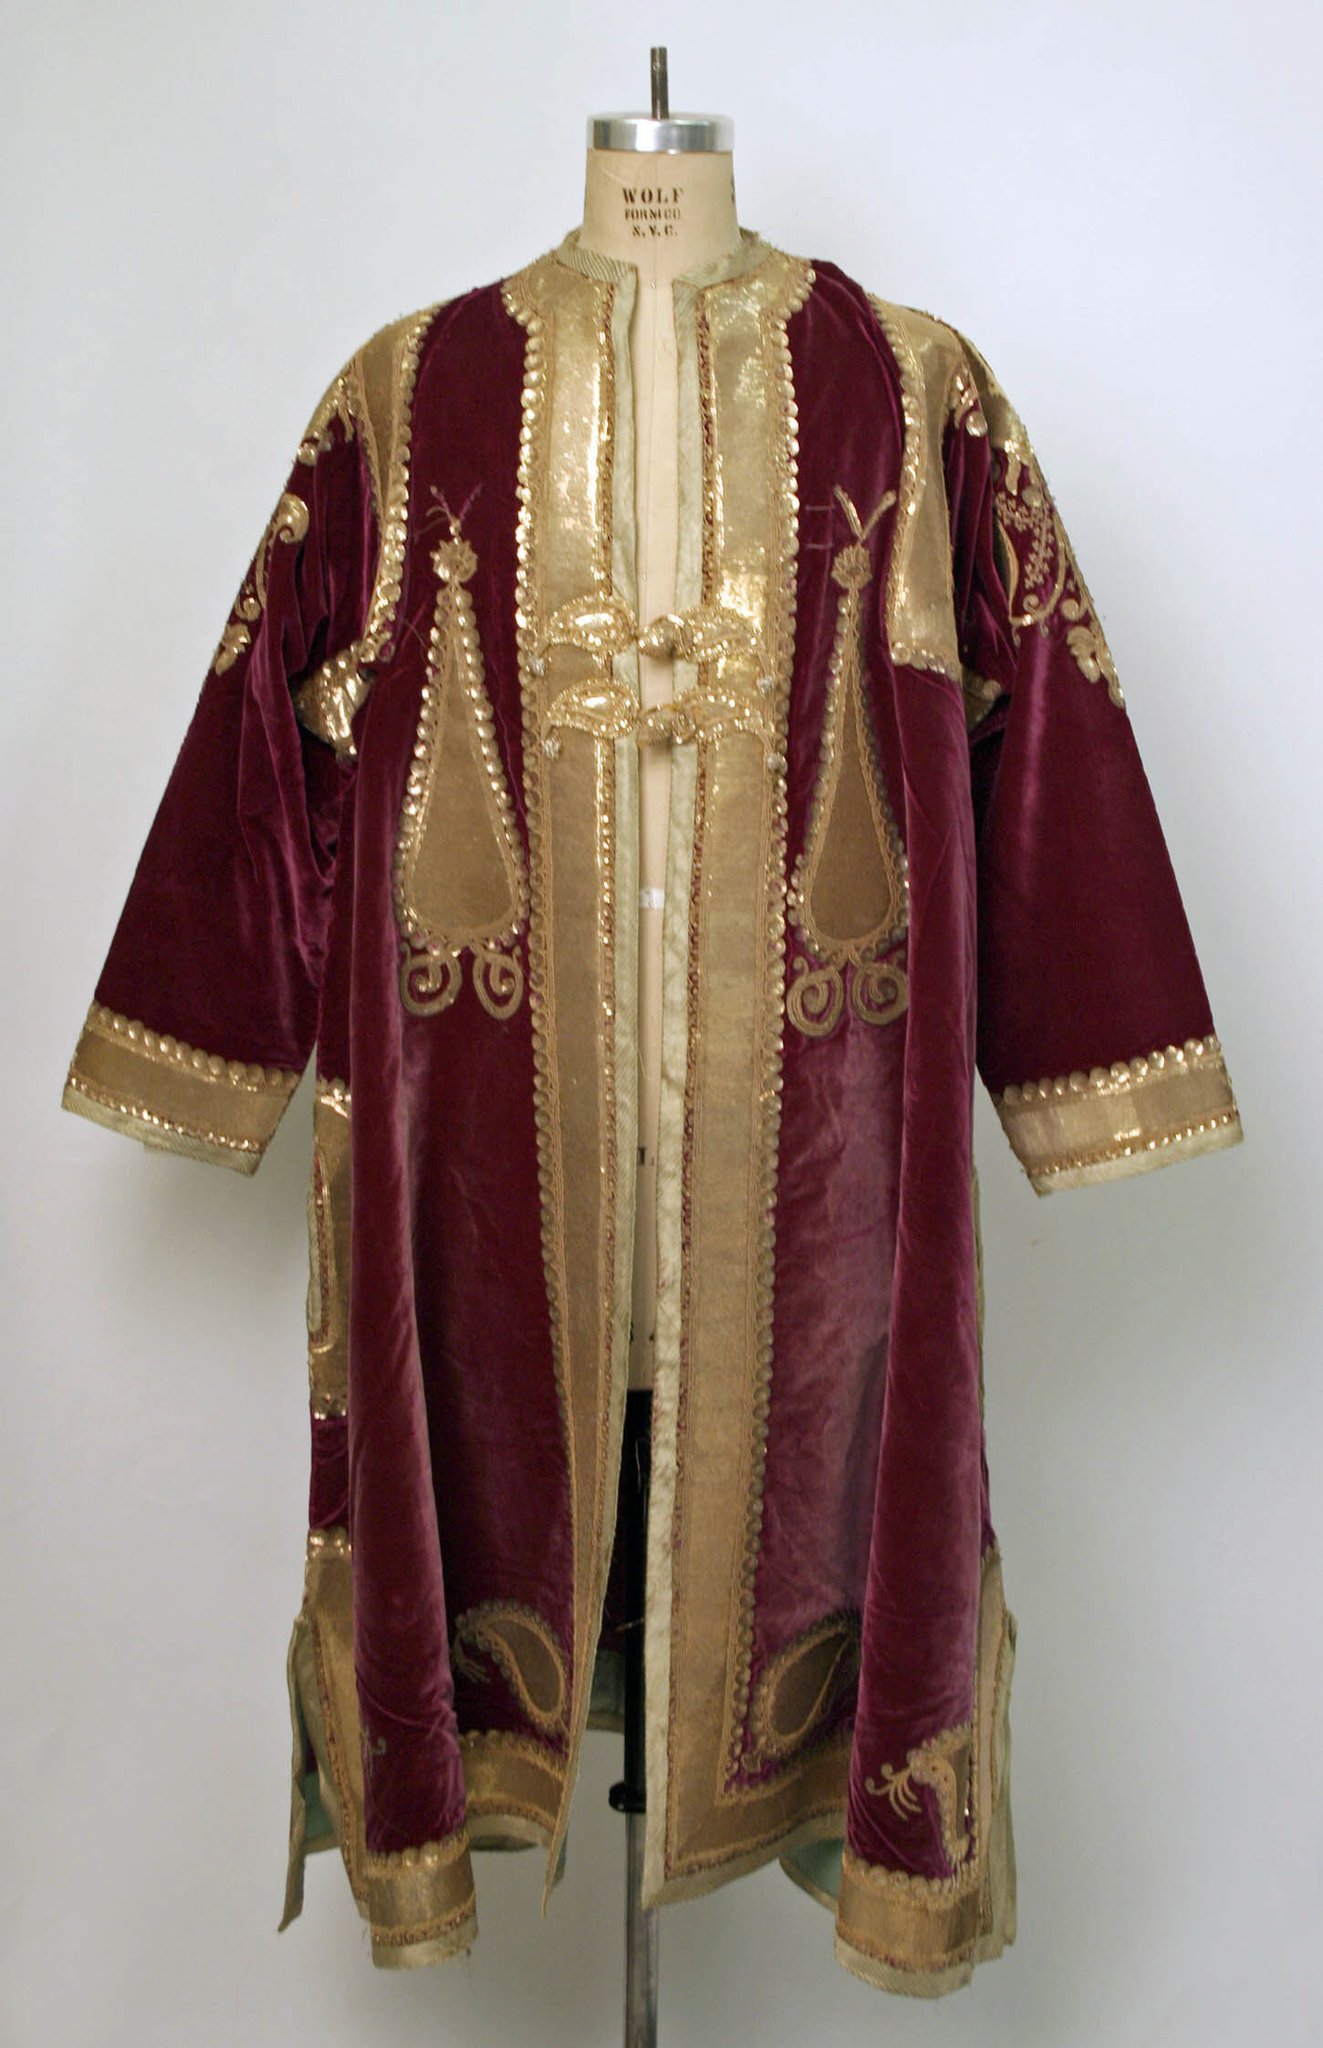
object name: coat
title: Choga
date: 1867-1900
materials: metal thread, silk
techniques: embroidery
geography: india